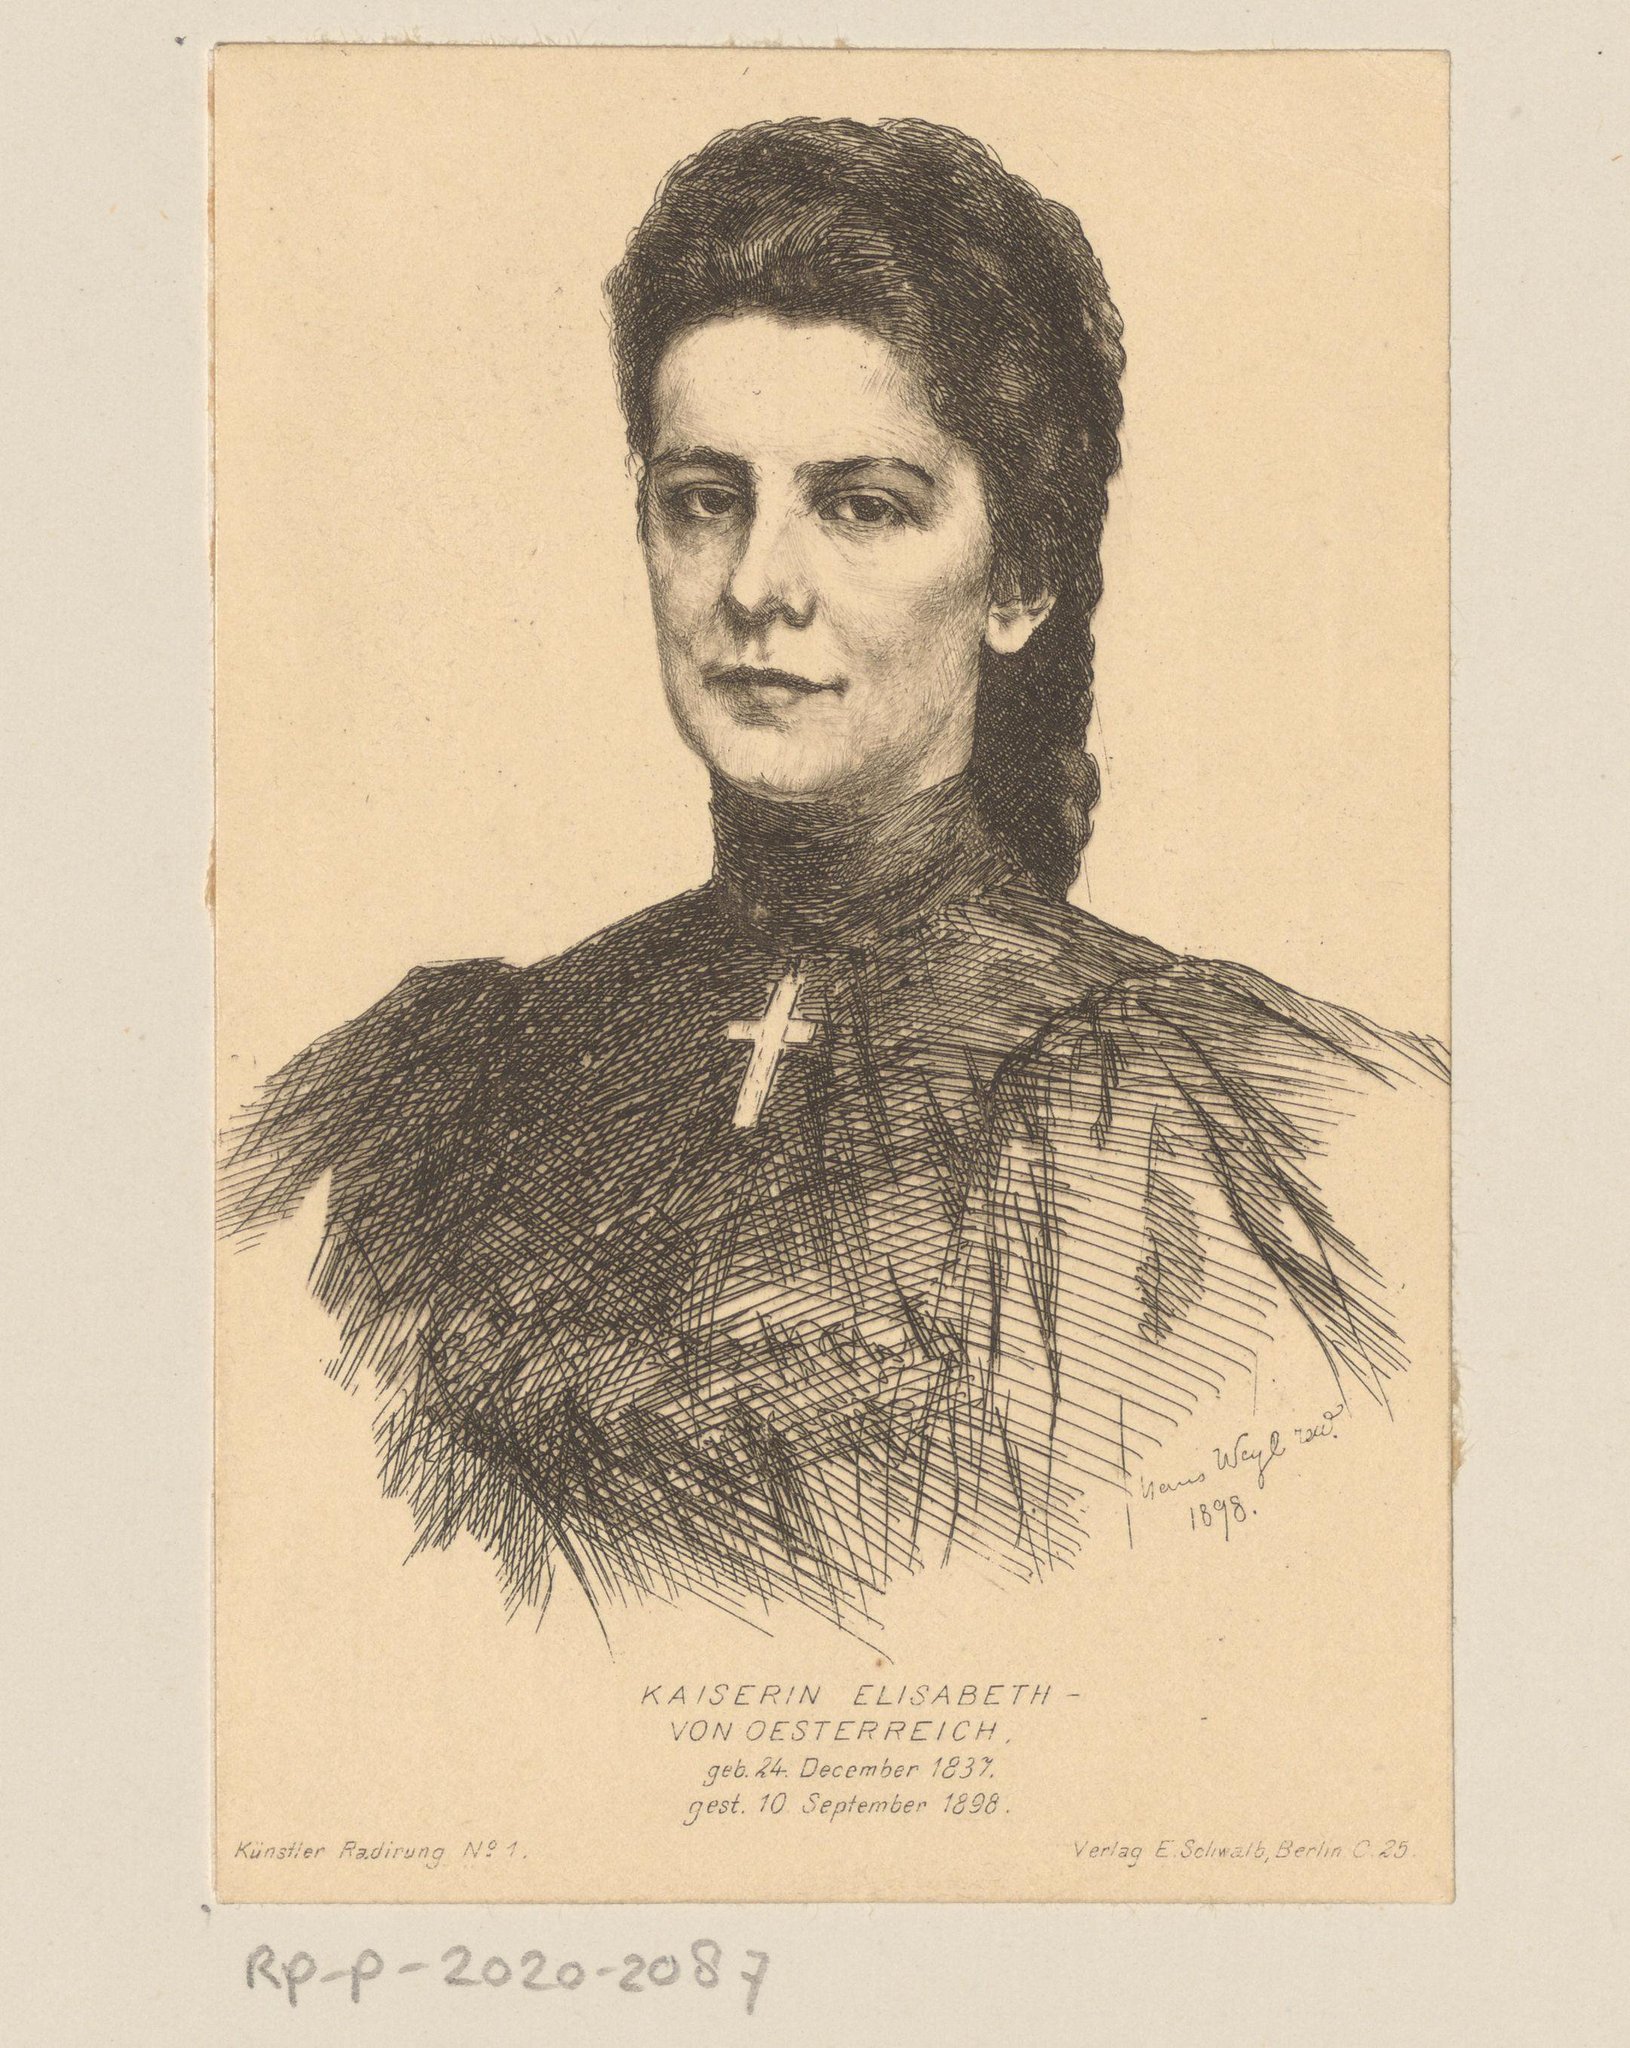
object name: print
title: Portret van Elisabeth in Beieren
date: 1898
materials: paper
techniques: etching, letterpress printing, retroussage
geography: berlin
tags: historical persons - bb - woman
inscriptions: date